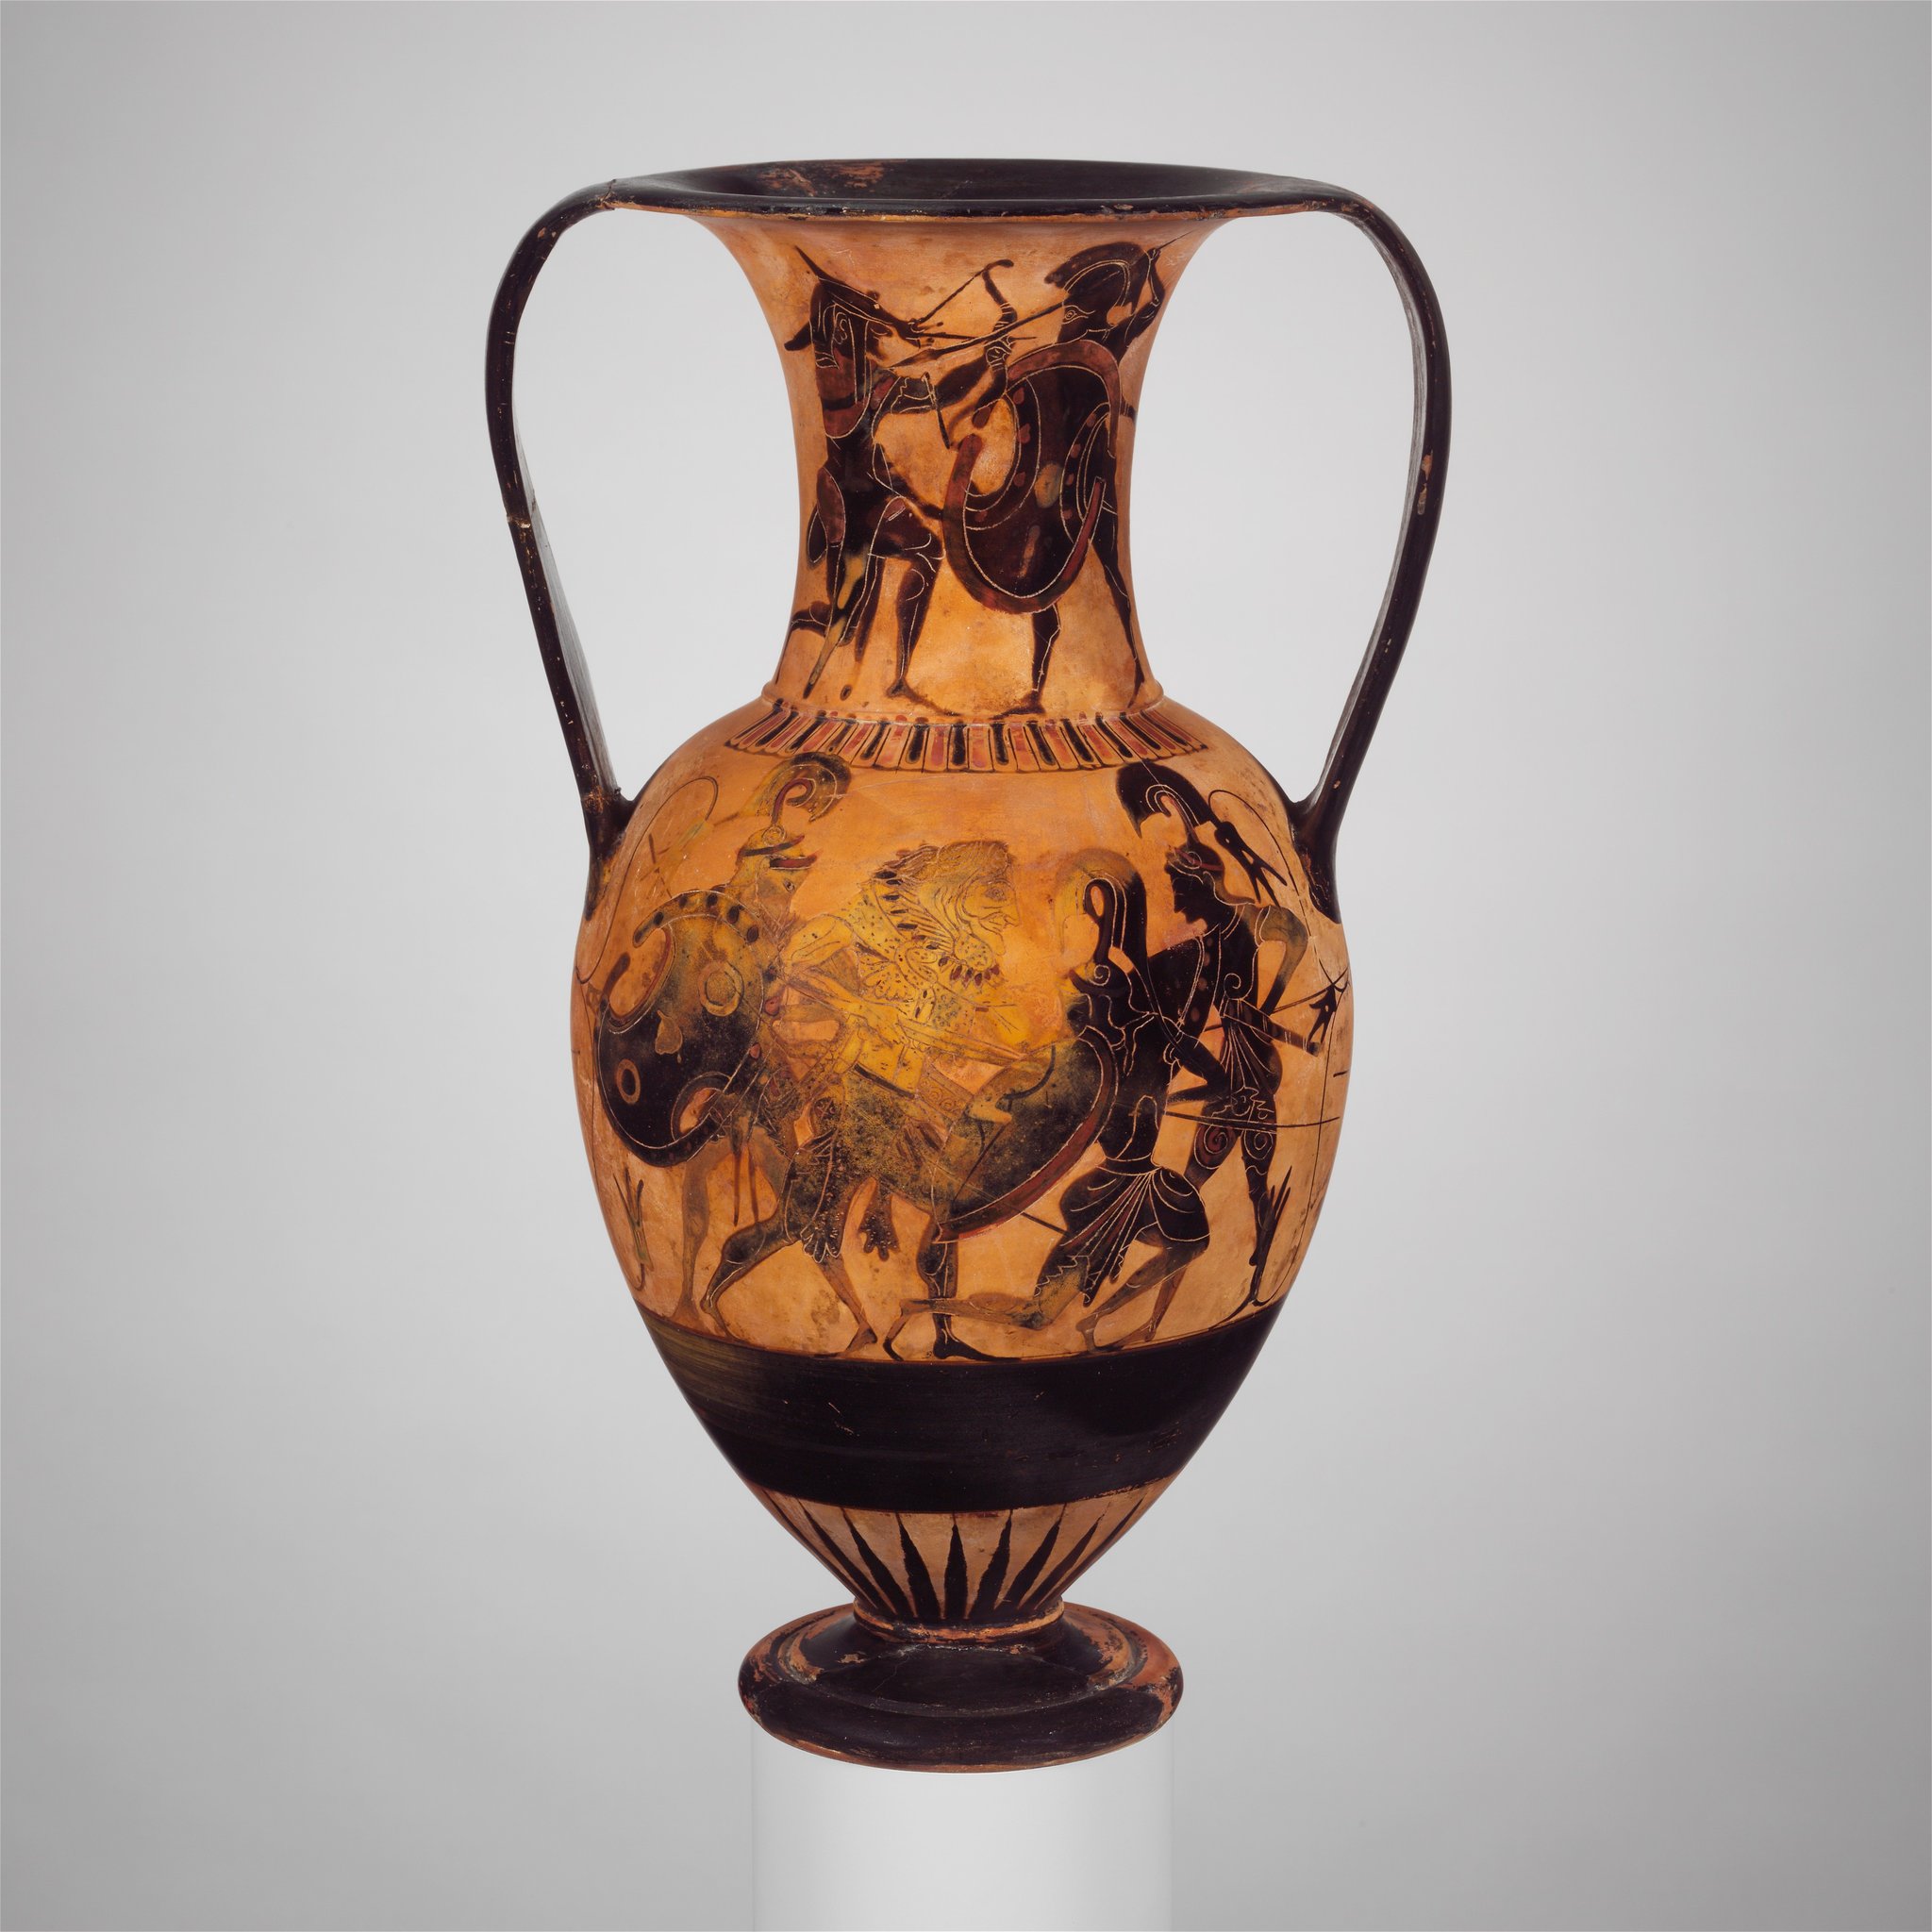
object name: nicosthenic neck amphora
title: Terracotta neck-amphora of Nicosthenic shape (jar)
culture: greek, attic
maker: class of cabinet des médailles 218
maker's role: artist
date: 510 BCE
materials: terracotta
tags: shields,dionysus,amazons,satyrs,herakles